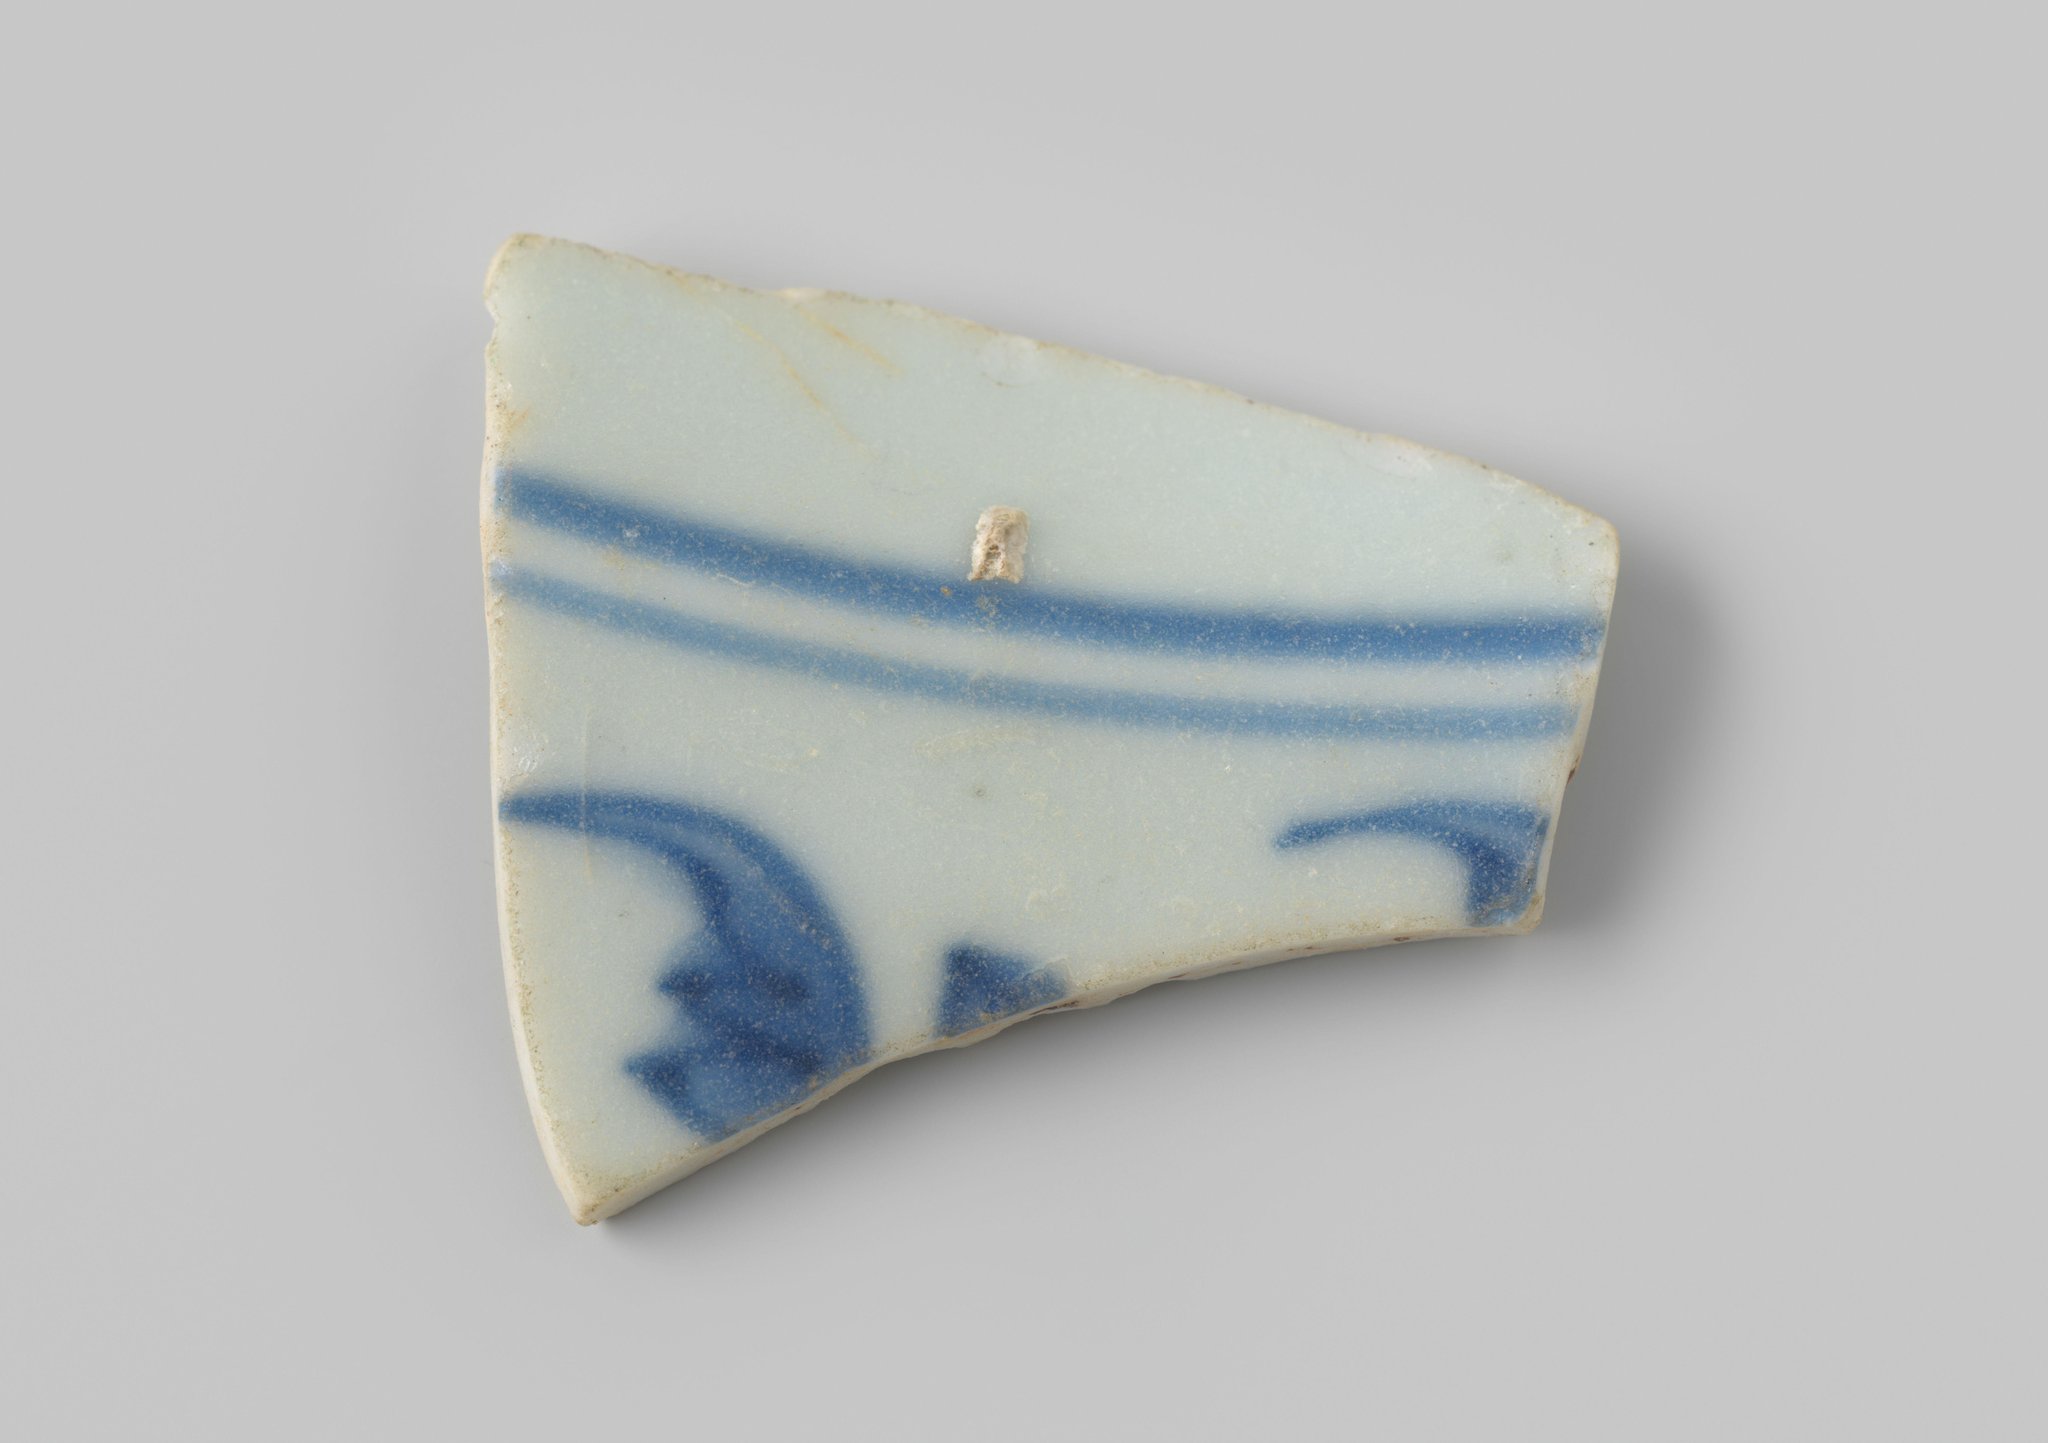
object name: platter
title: Scherf van een schotel uit het wrak van de Oost-Indiëvaarder Hollandia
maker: Anonymous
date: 1700-1743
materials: porcelain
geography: netherlands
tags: verenigde oostindische compagnie, hollandia (schip), annet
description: Porcelain, dish, fragment; fragm of rim, flattened, decorated.